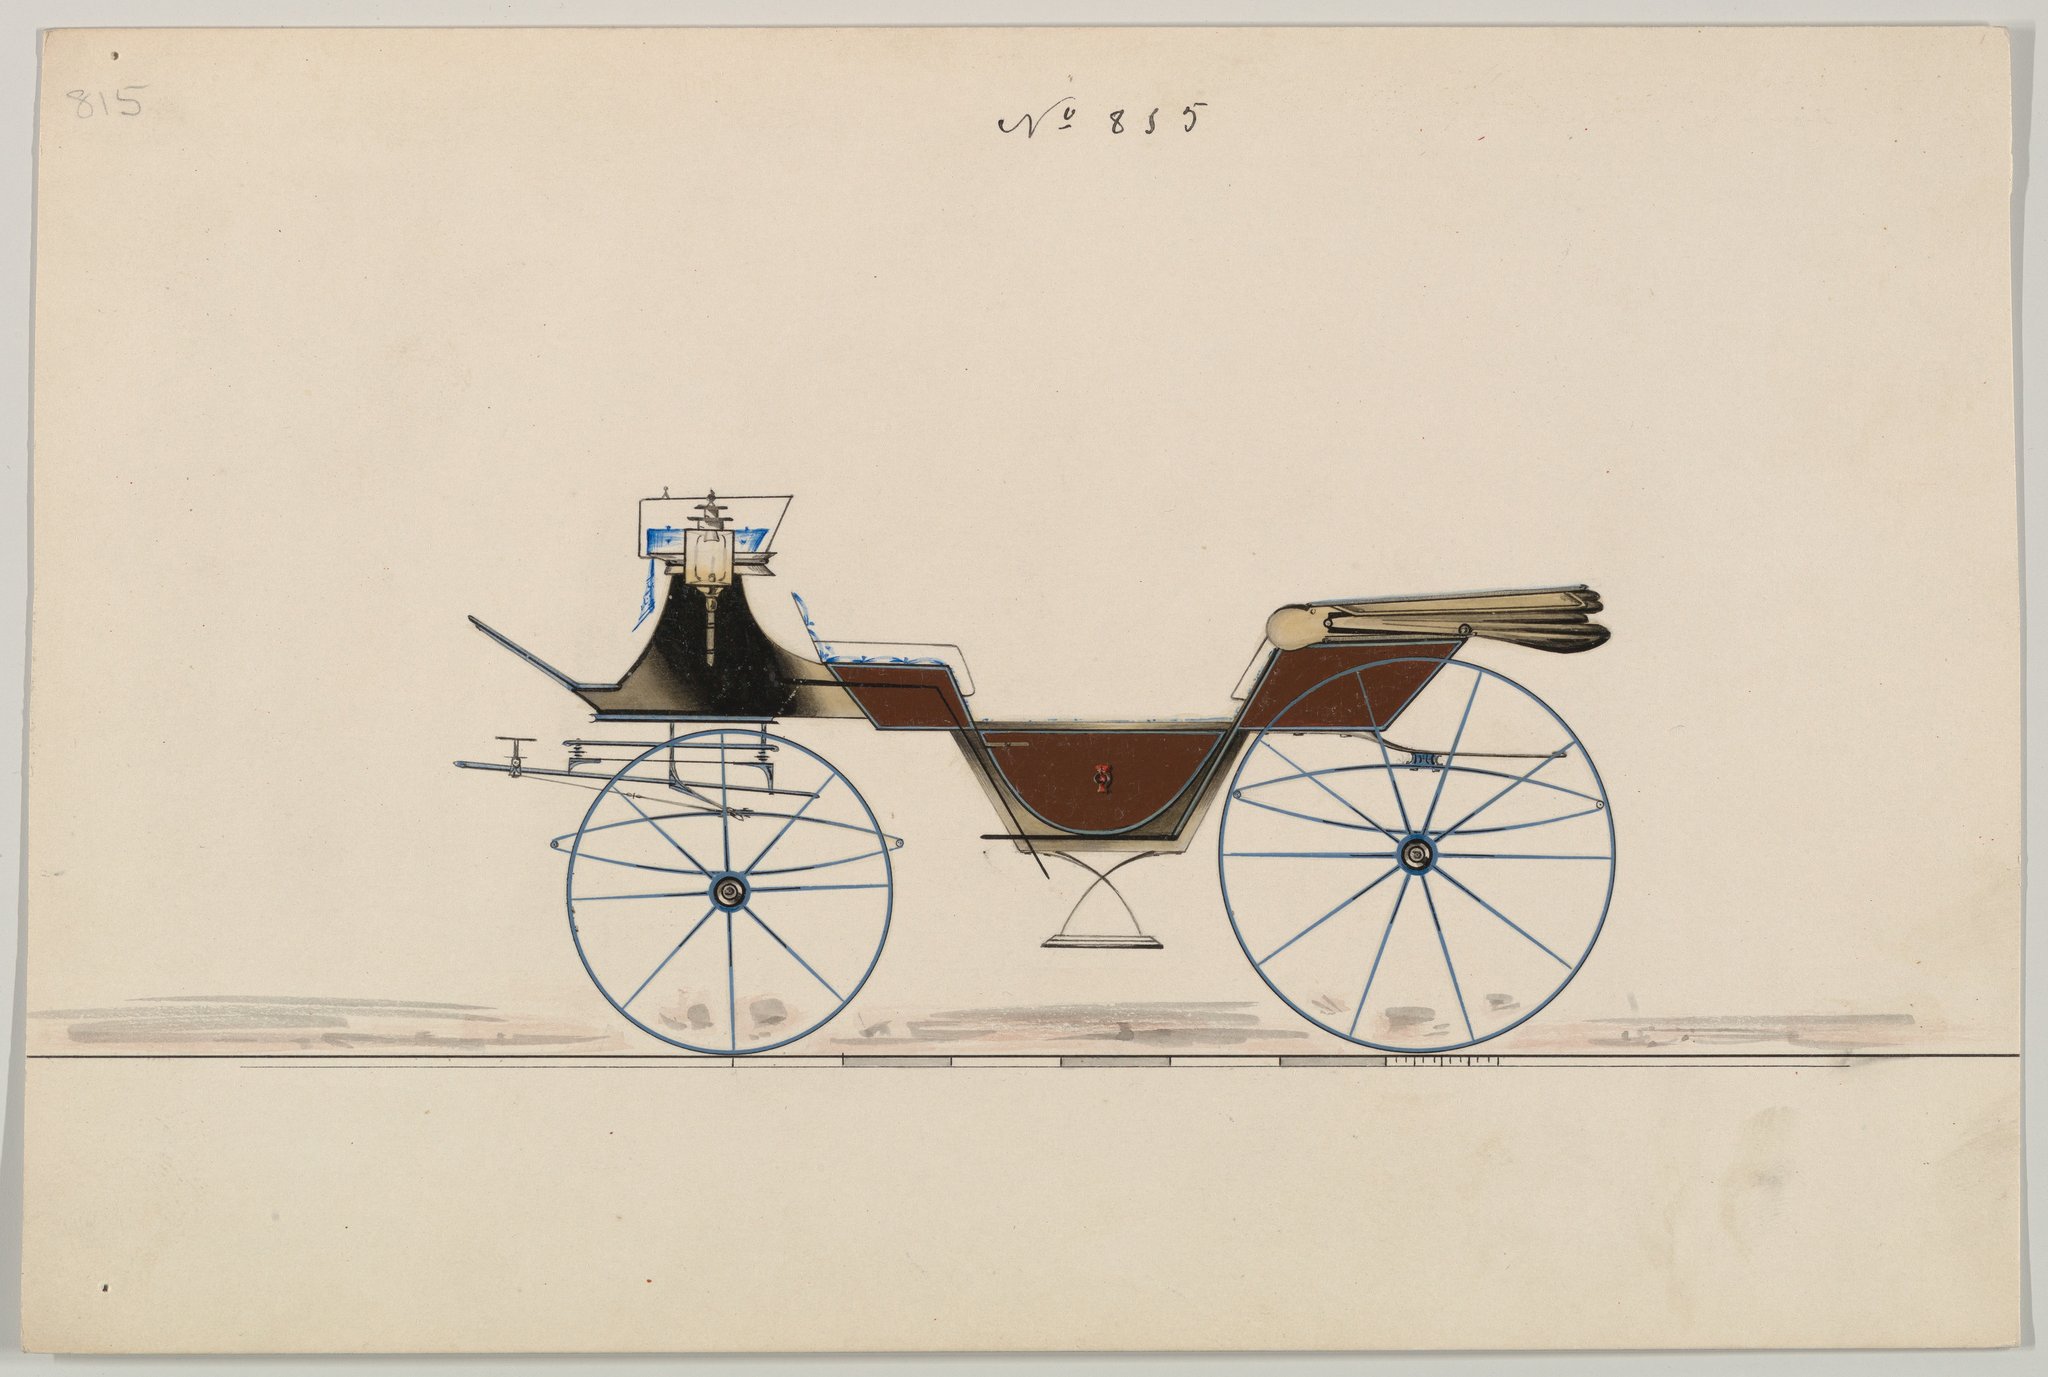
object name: drawing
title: Design for Vis-à-vis, no. 815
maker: brewster & co.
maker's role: manufacturer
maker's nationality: american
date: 1850-1870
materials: gouache, gum arabic, ink, watercolor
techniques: pen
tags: carriages